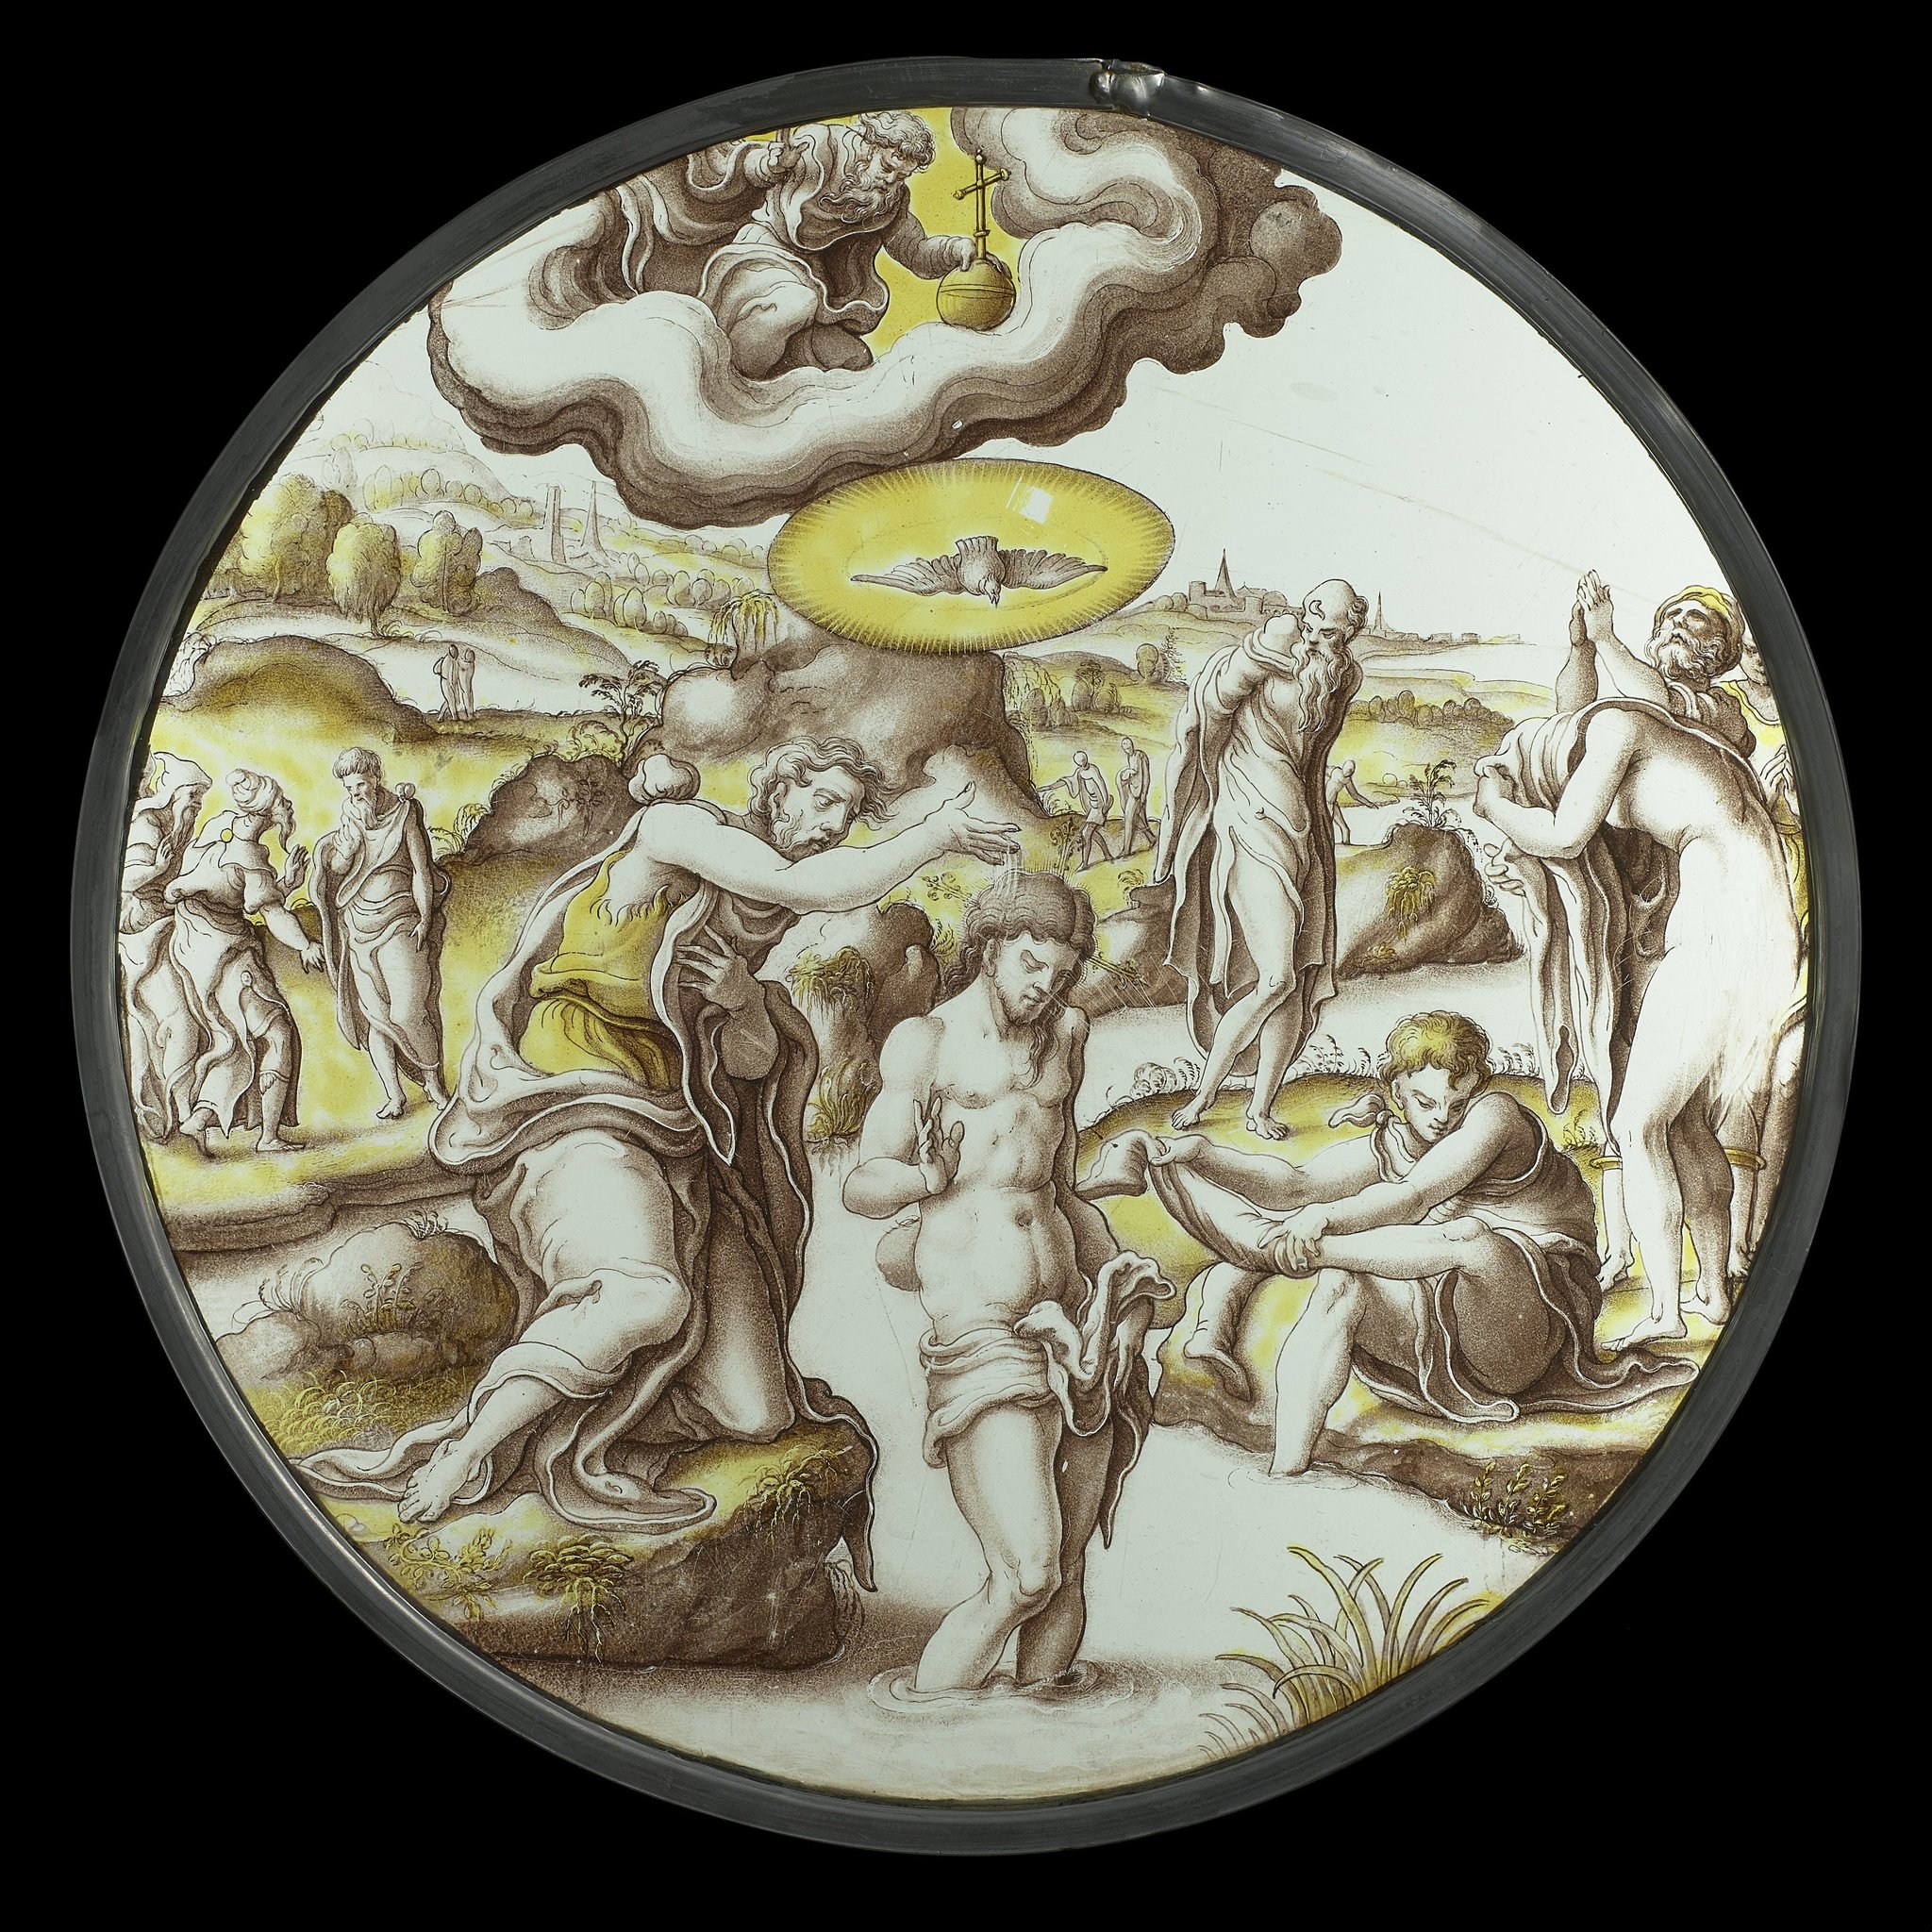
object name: light window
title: The Baptism of Christ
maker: Anonymous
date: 1540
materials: glass, lead, pigment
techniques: leading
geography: southern netherlands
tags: baptism of christ in the river jordan: john the baptist pouring out water on christ's head: the holy ghost descends, god the father represented as human being, usually with crown or tiara or sceptre and/or globe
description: Ronde gebrandschilderde ruit met voorstelling van de Doop van Christus. Christus, die een lendendoek draagt, staat tot halverwege zijn knieën in het water van de Jordaan. Johannes knielt op de oever, ten teken van zijn nederigheid ten opzichte van Christus, en giet uit de palm van zijn hand water over het hoofd van Christus. Boven zijn hoofd zweeft een duif in een stralenkrans, de Heilige Geest. Daarboven zien we God de Vader, die vanuit een wolkenpartij toekijkt en een zegenend gebaar maakt. Rechts ontkleden zich gelovigen om zich in het water te laten dopen.